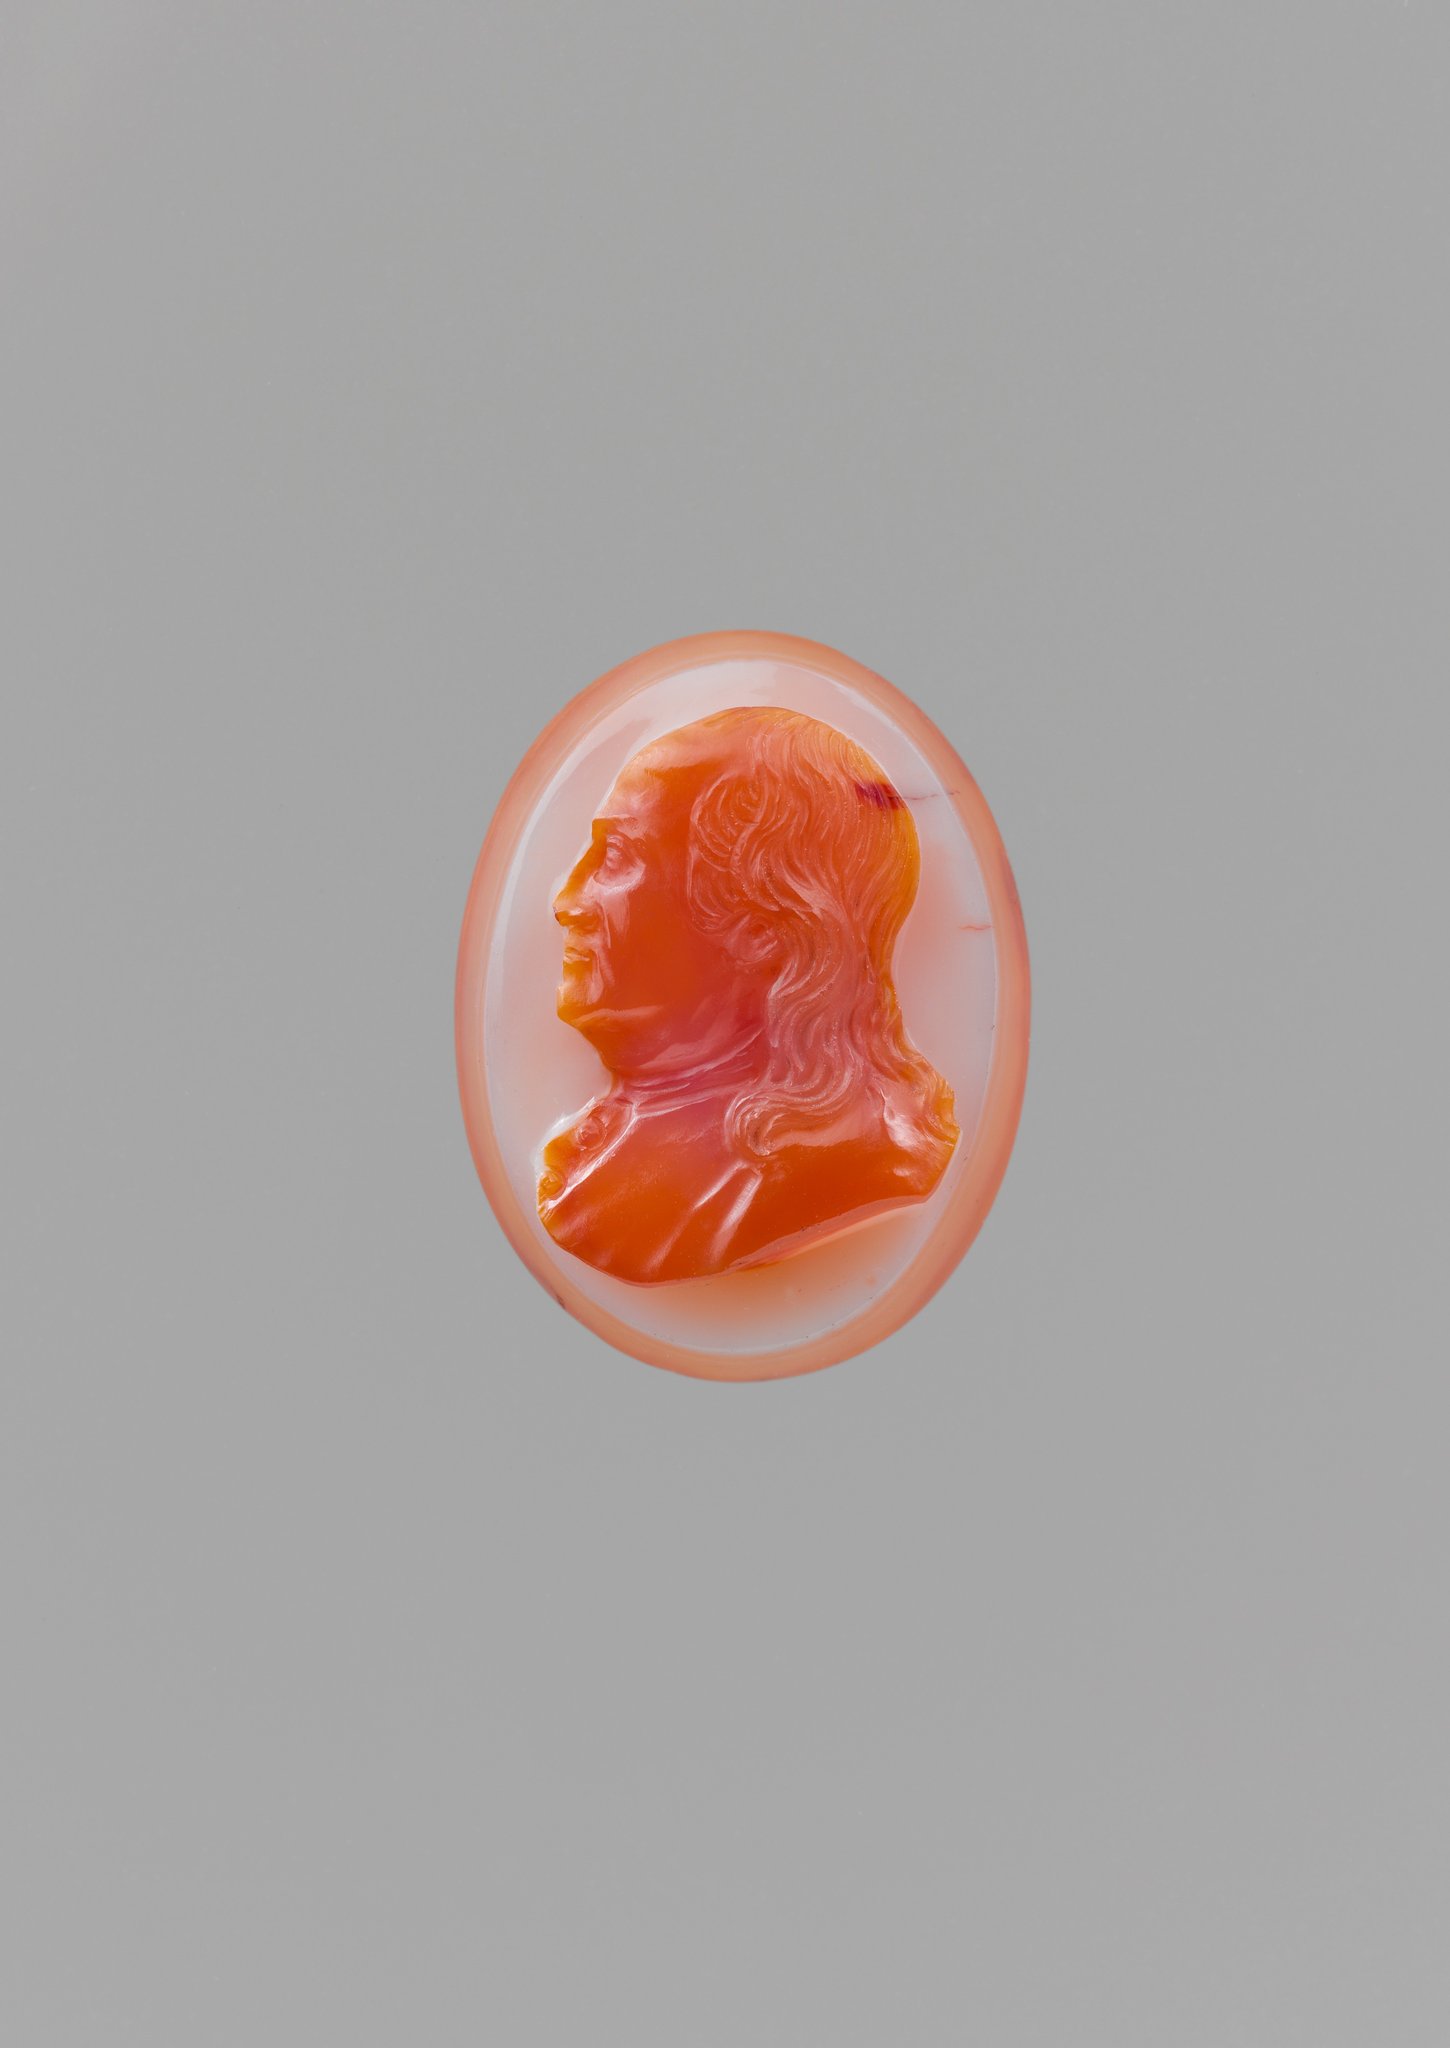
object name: plaque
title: George Washington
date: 1825-1850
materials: gemstone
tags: george washington,men,profiles